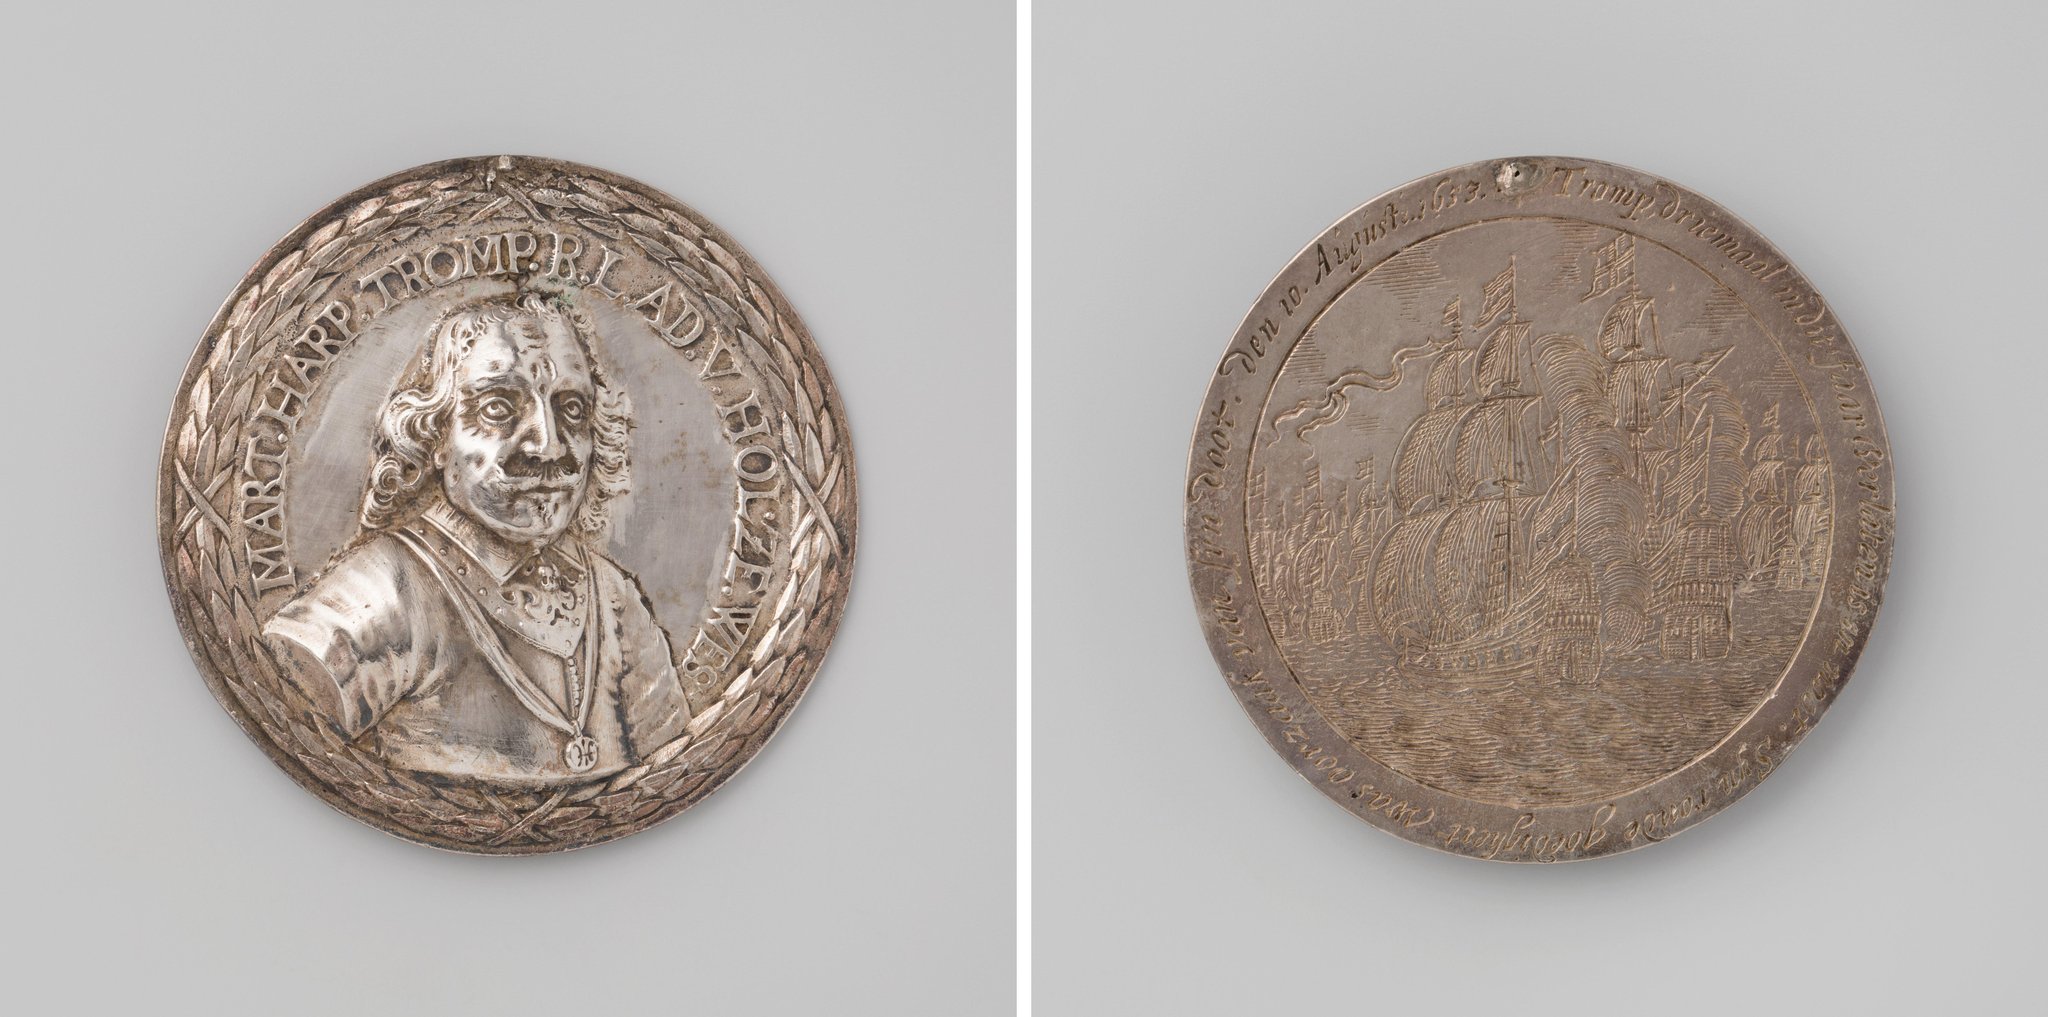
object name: overlijdenspenning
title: Dood van Maarten Harpertsz. Tromp, gesneuveld bij Katwijk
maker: wouter muller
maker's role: publisher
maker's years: 1604-1673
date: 1653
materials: silver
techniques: casting, engraving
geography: amsterdam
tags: maarten harpertszoon tromp, battle of scheveningen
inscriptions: circumscription: ‘MART HARP TROMP R L AD V HOL ZE WES’, circumscription: ‘Tromp driemaal in dit jaar verlaten is in noot sijn ronde goedigheit was oorzaak van sijn doot den 10 Augusti 1653’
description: Zilveren penning. Voorzijde: borststuk man met ordeteken van Sint Michaël binnen omschrift en lauwerkrans. Keerzijde: zeeslag binnen omschrift.